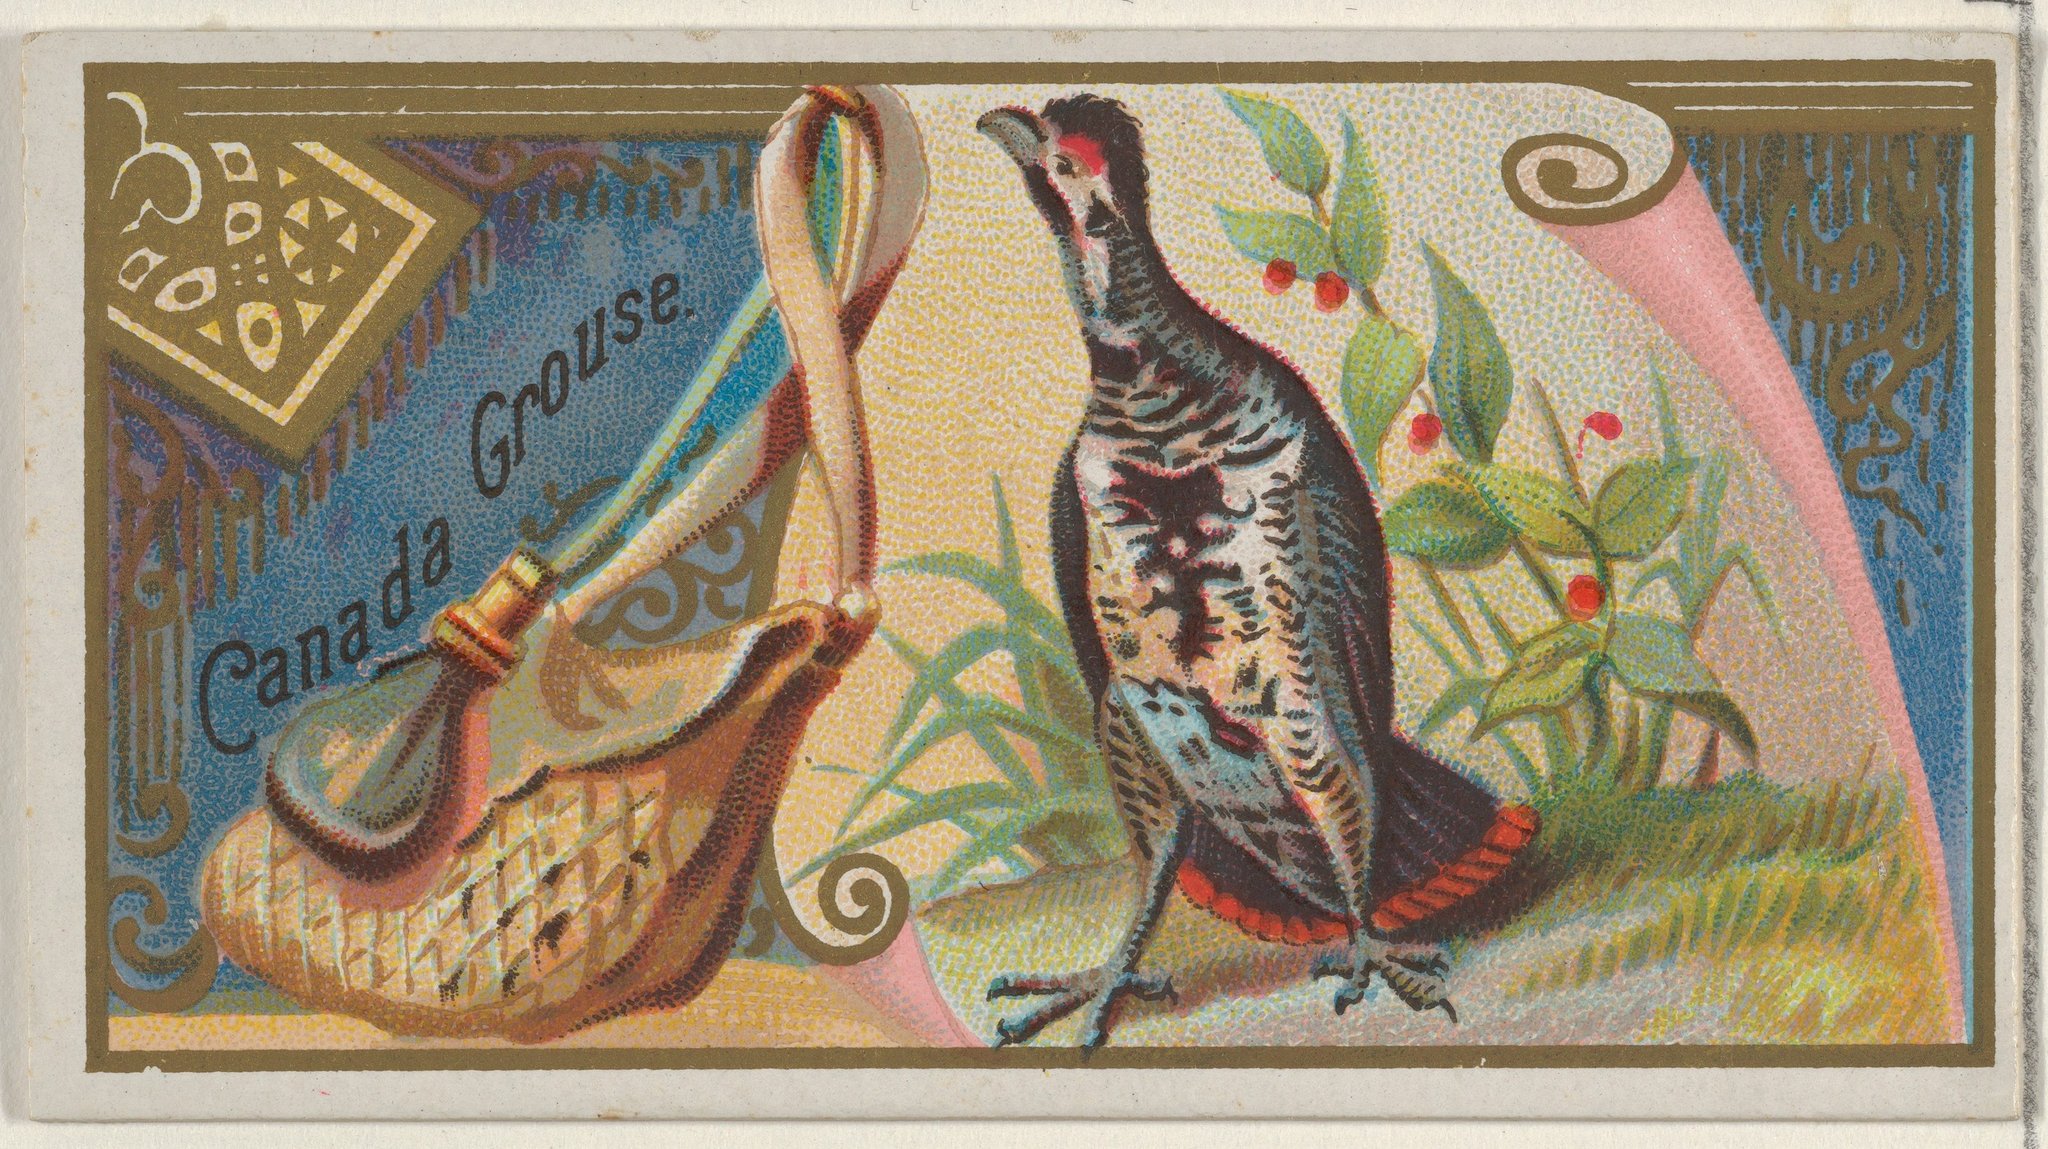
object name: print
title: Canada Grouse, from the Game Birds series (N13) for Allen & Ginter Cigarettes Brands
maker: allen & ginter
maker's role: publisher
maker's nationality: american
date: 1889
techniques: color lithograph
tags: birds